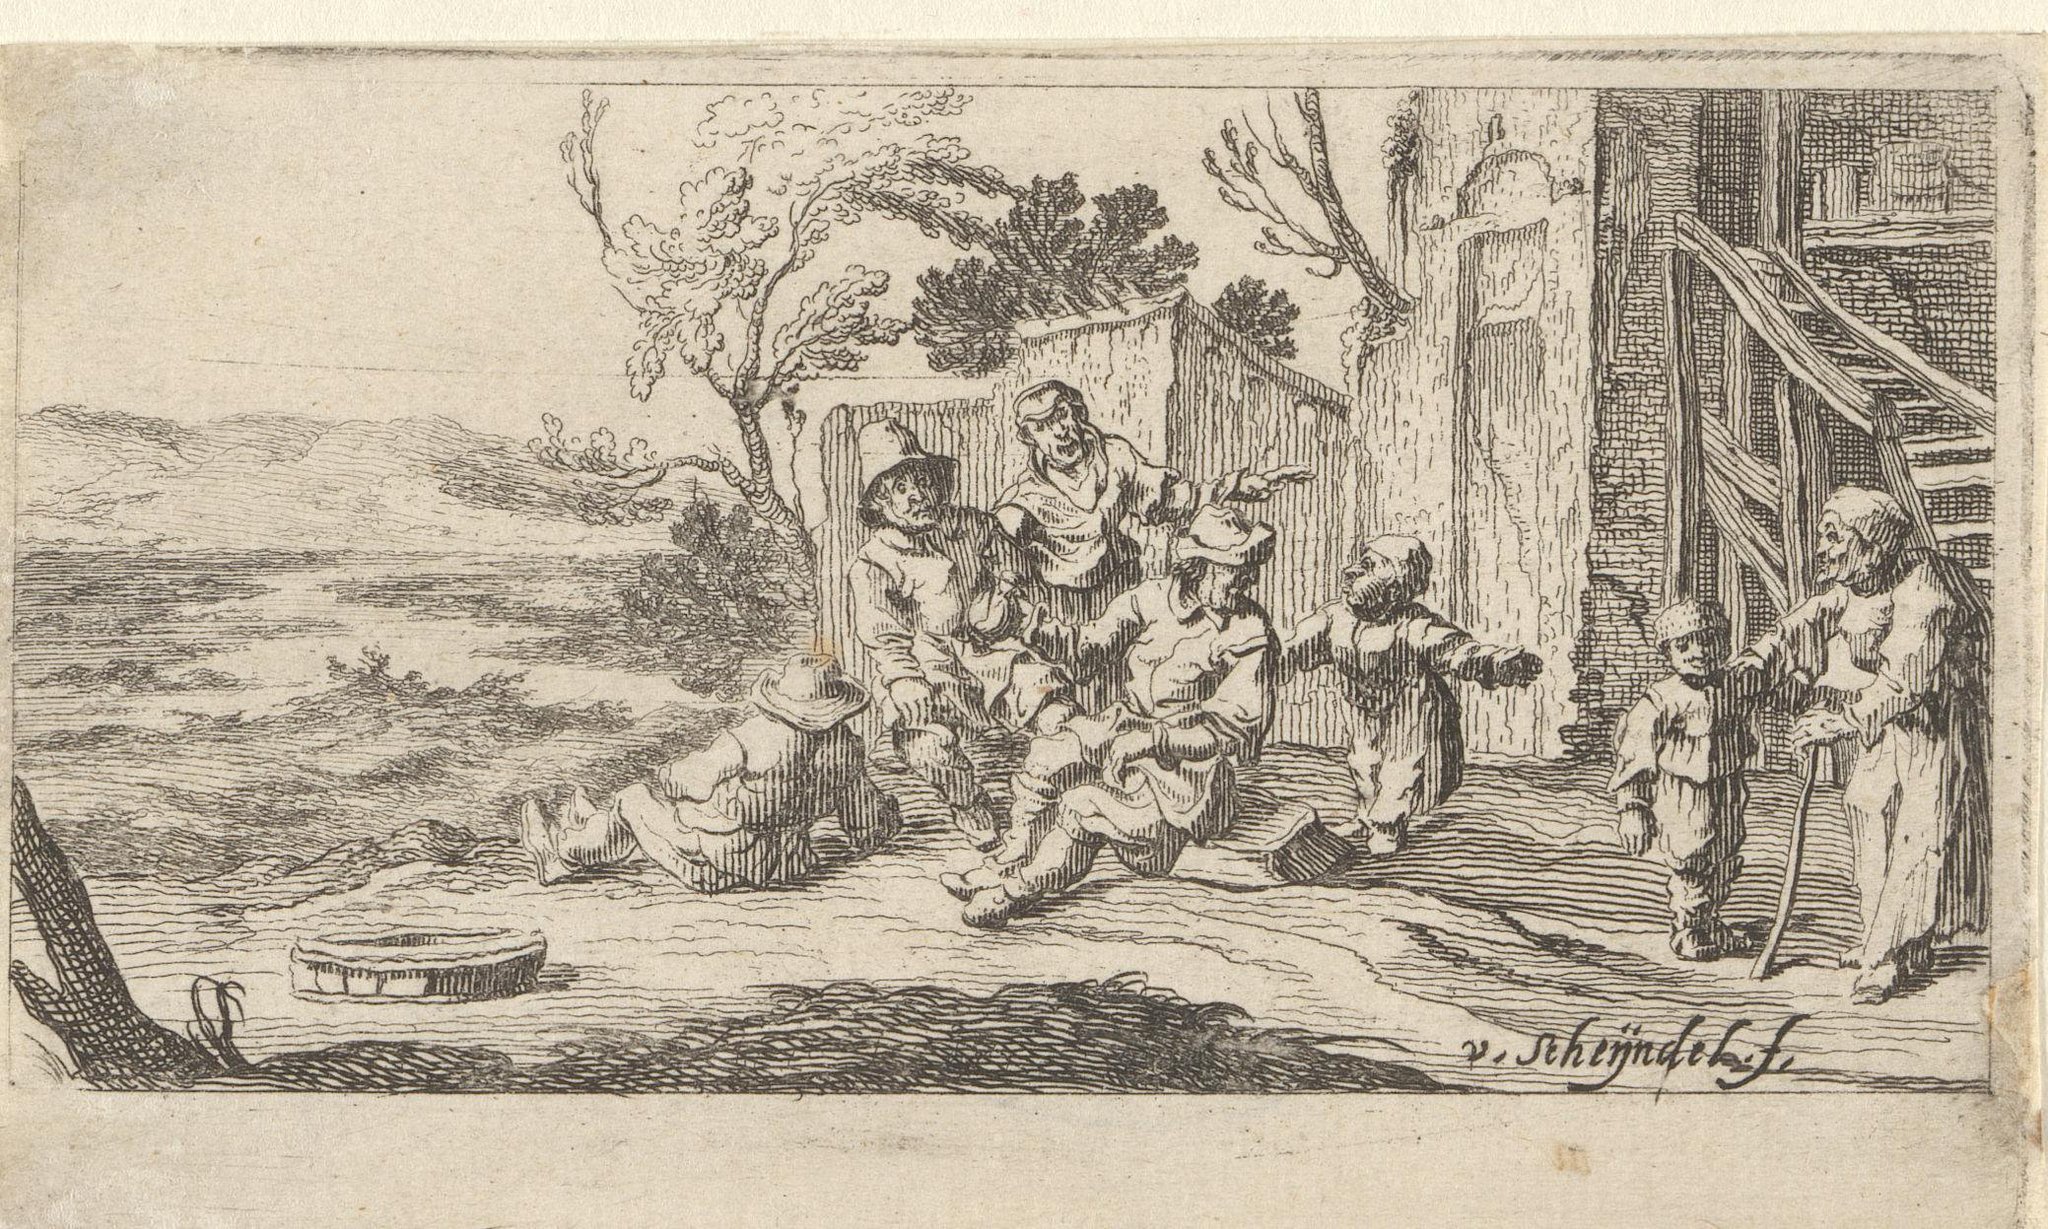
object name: print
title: Groep rustende boeren voor een gebouw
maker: gillis van scheyndel (i)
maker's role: draughtsman, print maker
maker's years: 1595-1660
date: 1603-1653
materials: paper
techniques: etching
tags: farmers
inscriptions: collector's mark: Lugt 2228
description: Prent maakt deel uit van een serie van in ieder geval vier prenten.